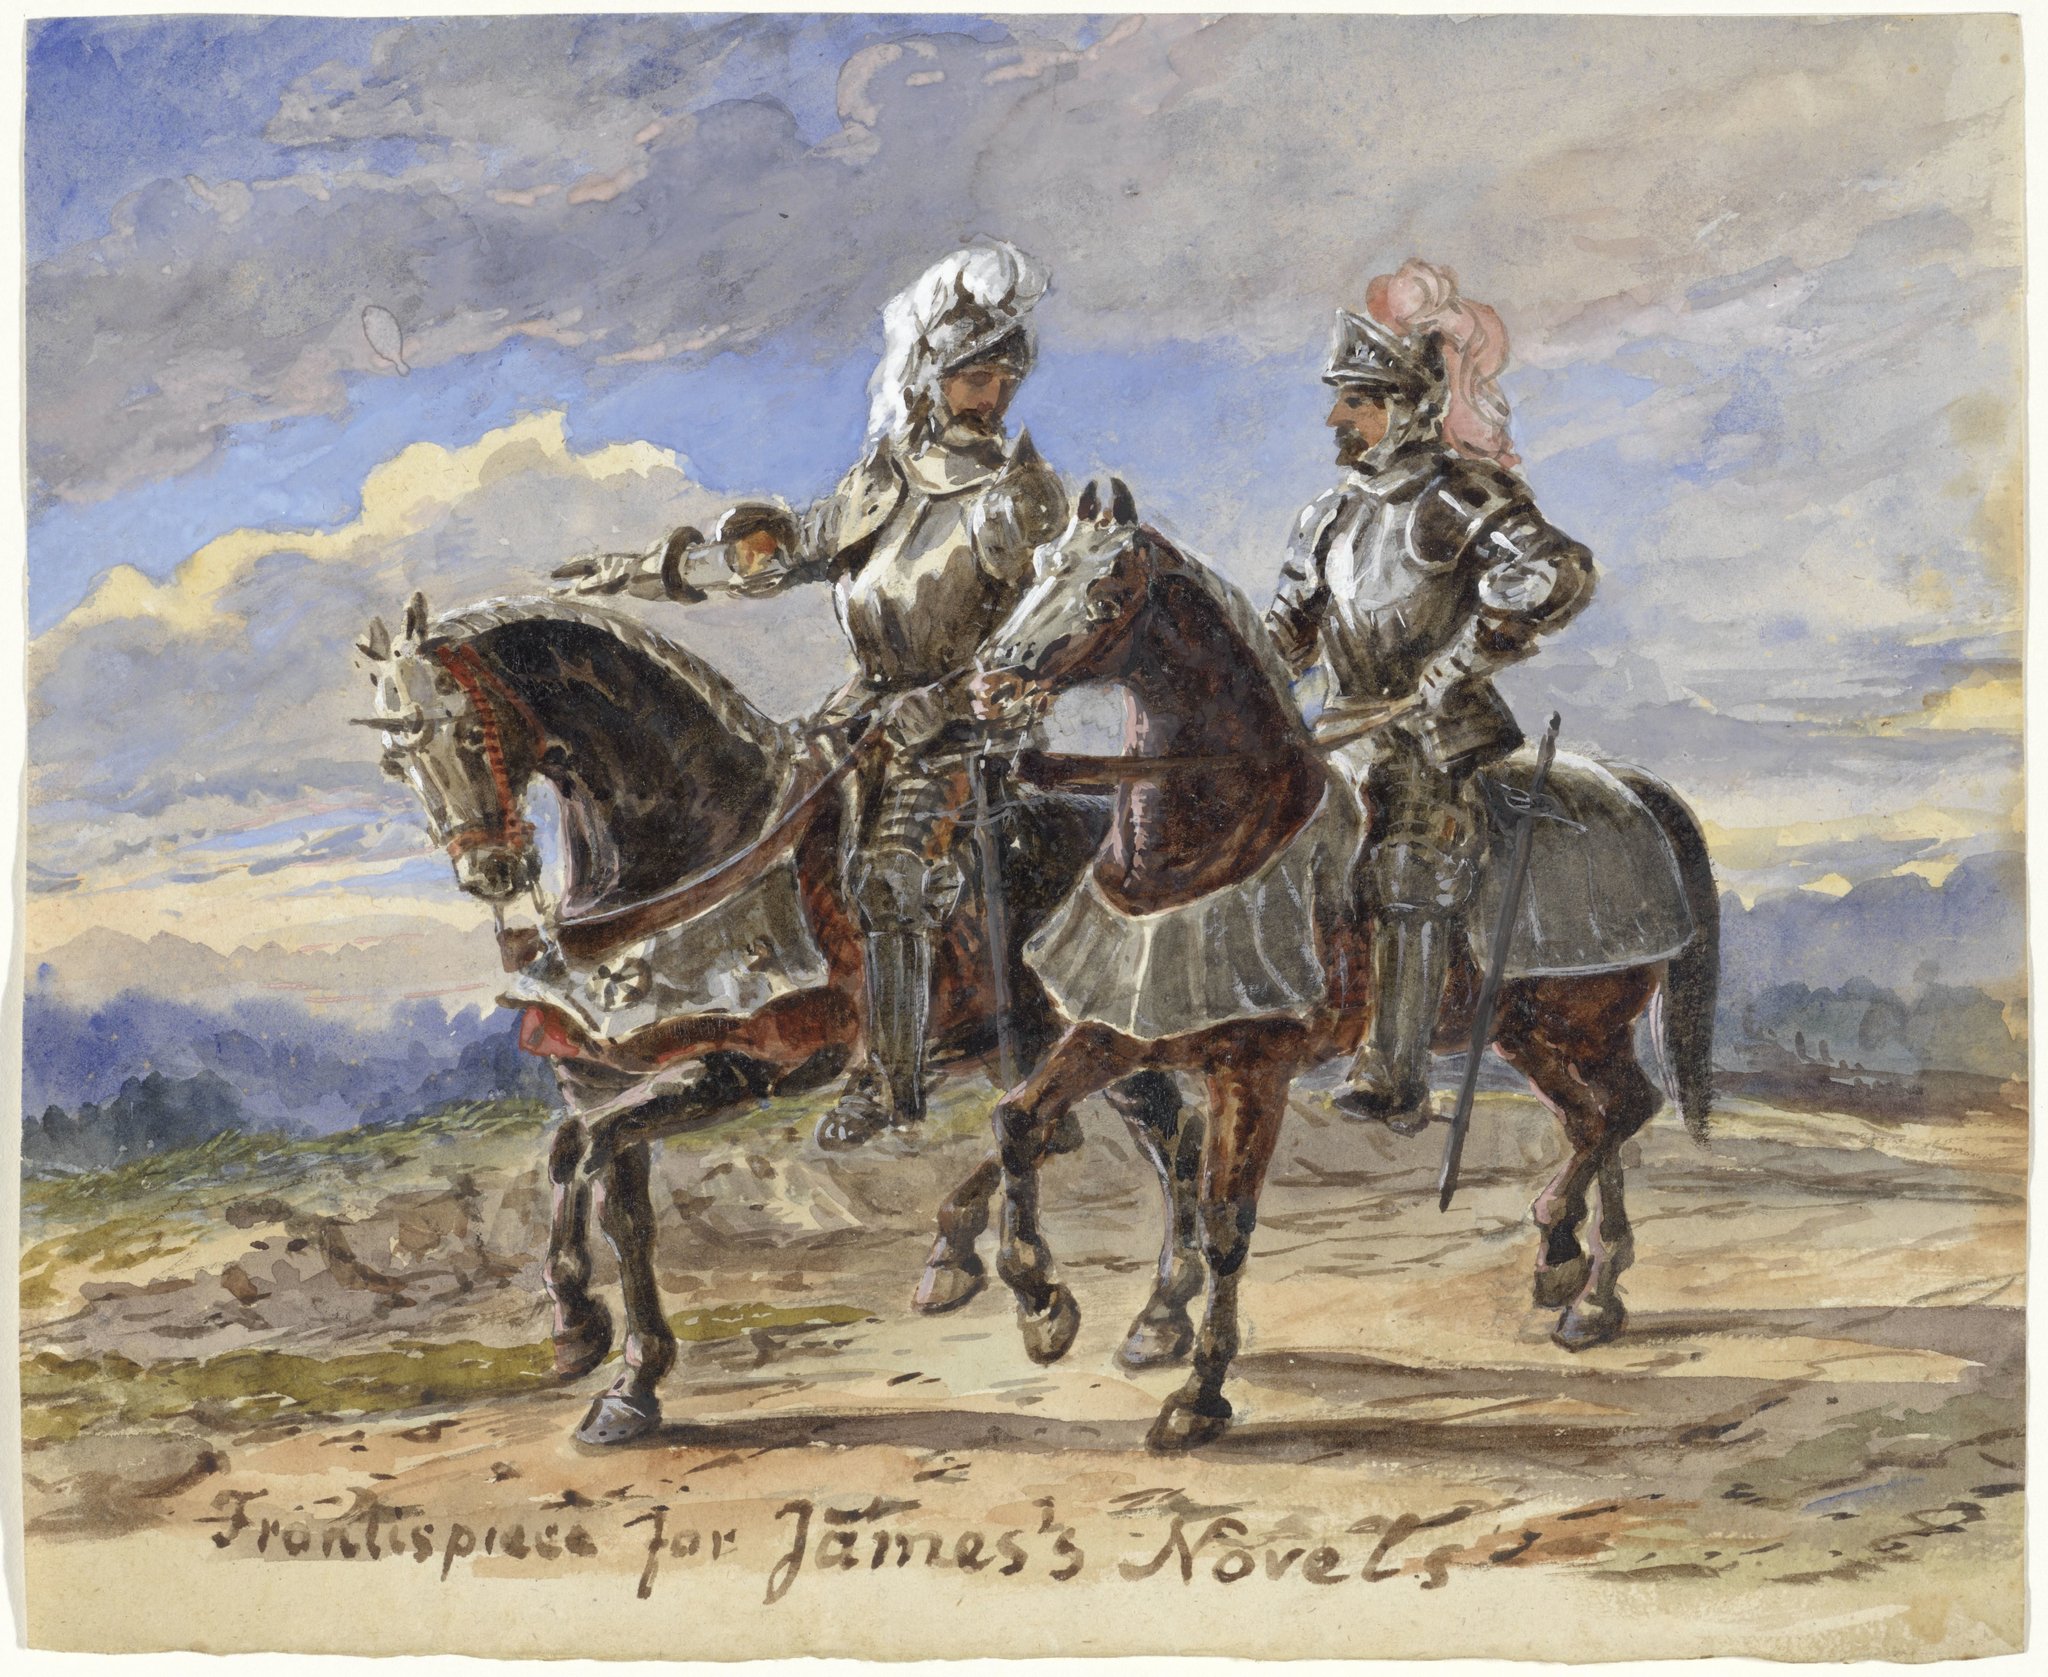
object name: drawing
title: Twee ridders te paard in een landschap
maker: pieter van loon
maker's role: draughtsman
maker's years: 1801-1873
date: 1811-1873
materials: paper, watercolor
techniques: brush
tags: knight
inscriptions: inscription: ‘Frontispiece for James's Novels’